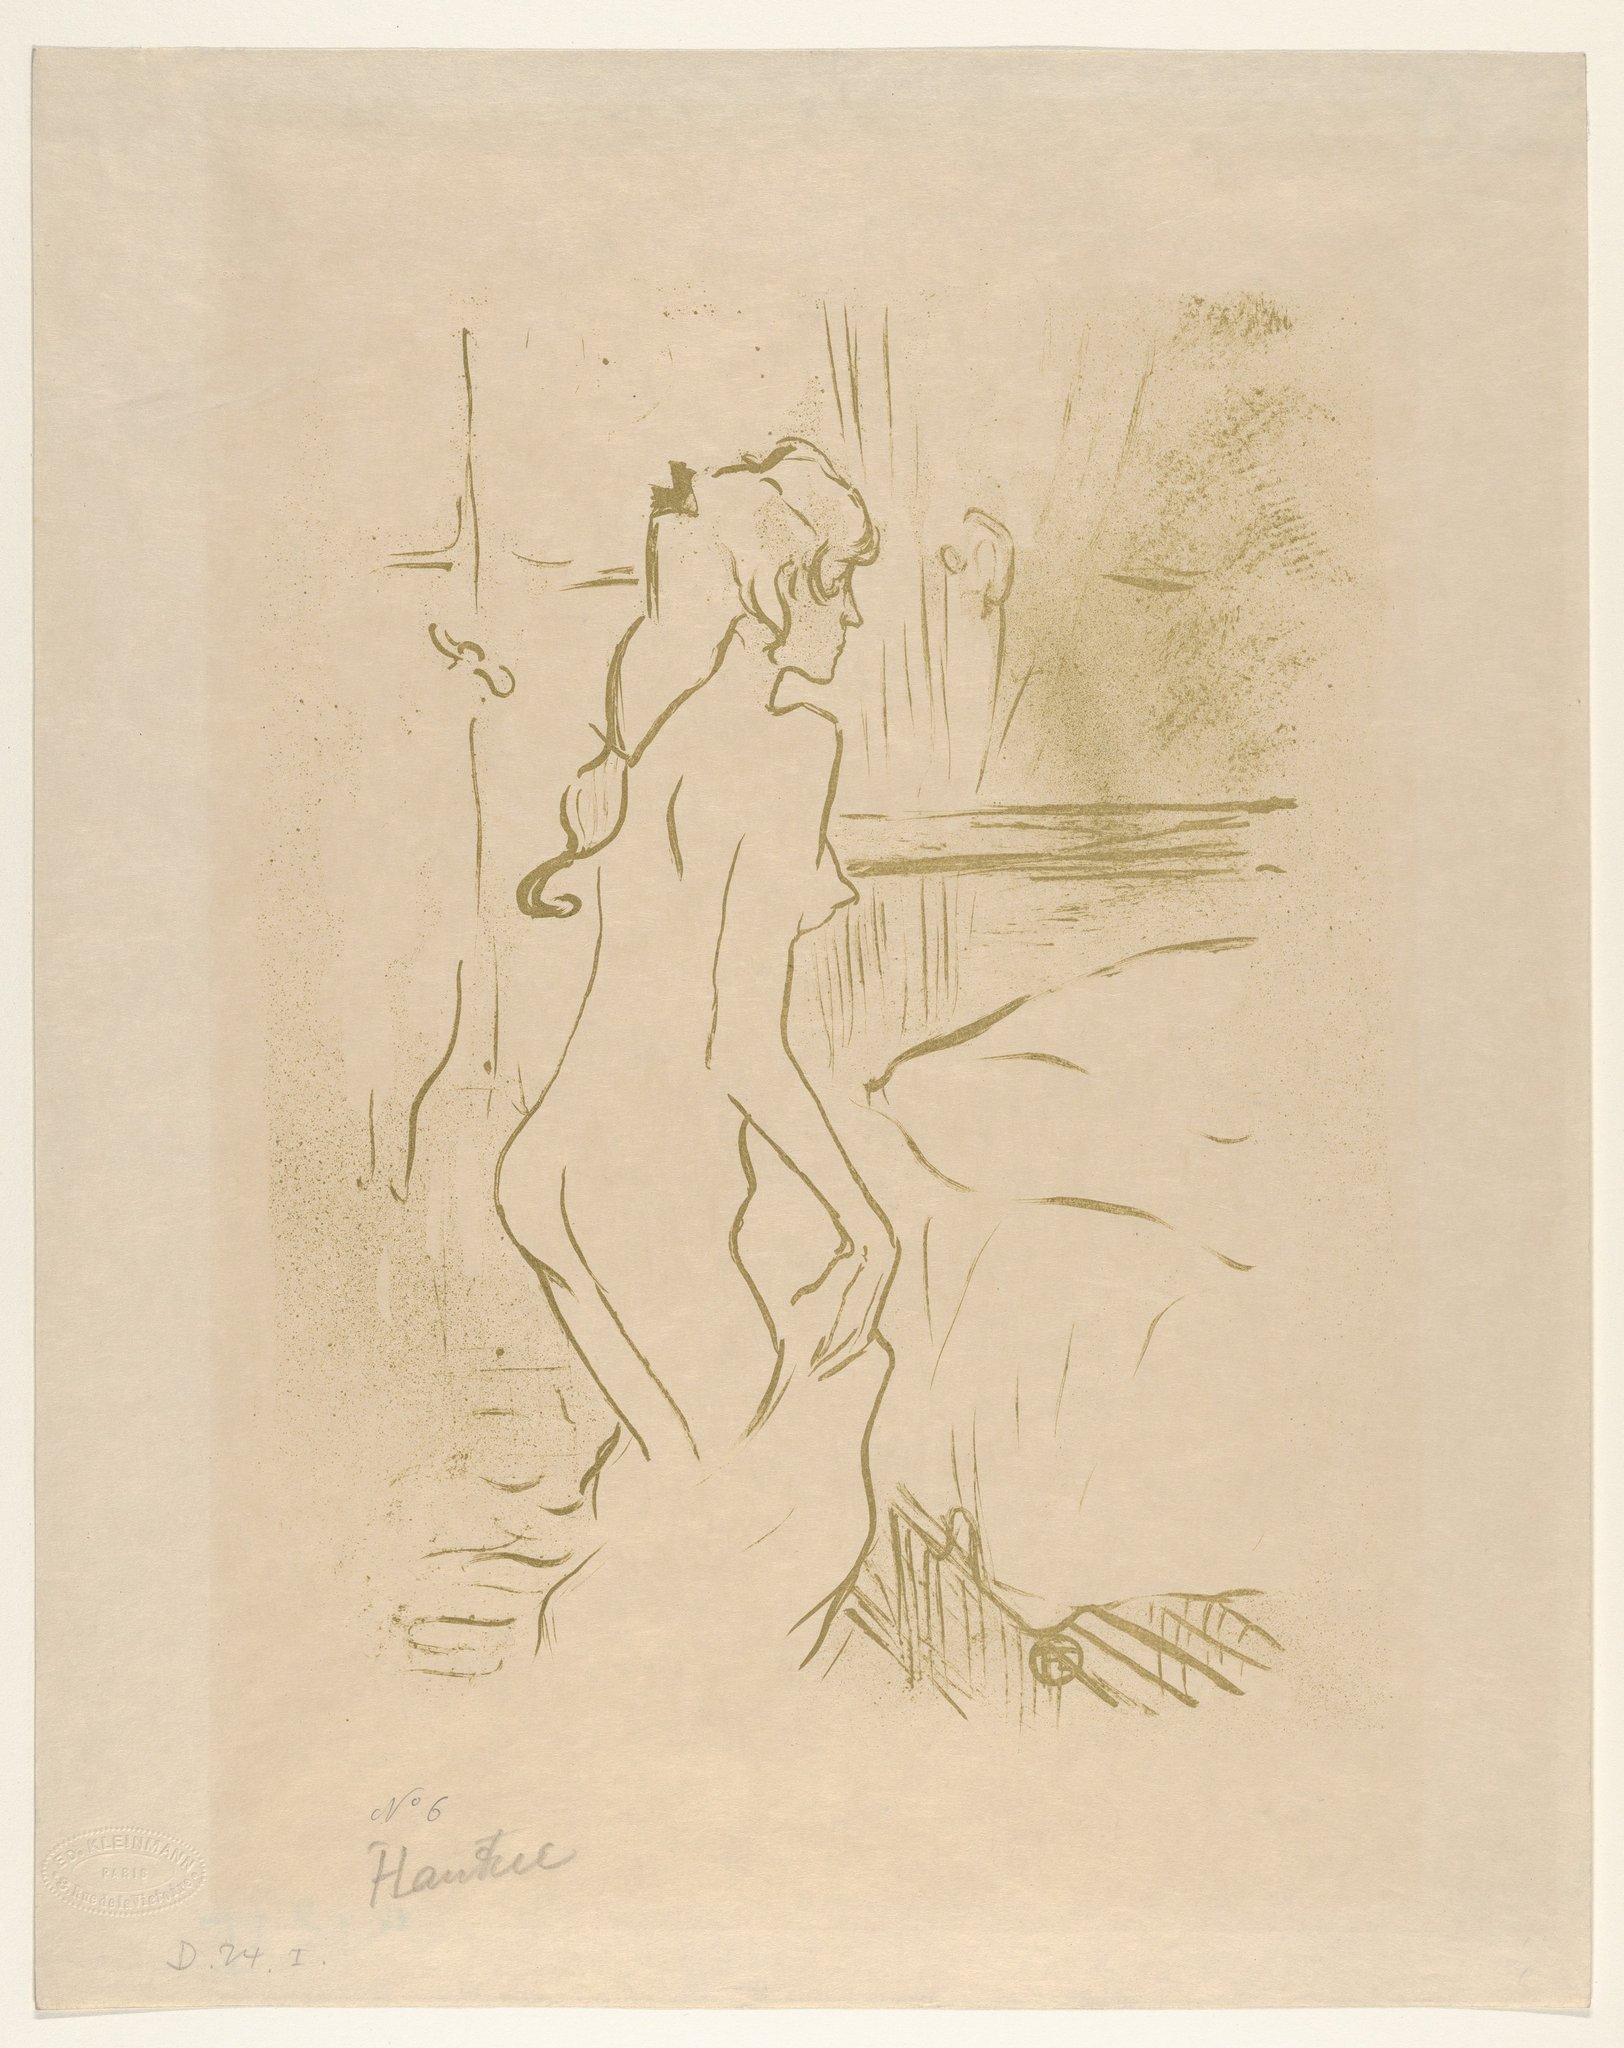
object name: print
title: Study of a Woman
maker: henri de toulouse-lautrec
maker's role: artist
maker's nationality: french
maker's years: 1864-1901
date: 1893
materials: ink, paper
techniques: brush, lithograph, printing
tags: female nudes